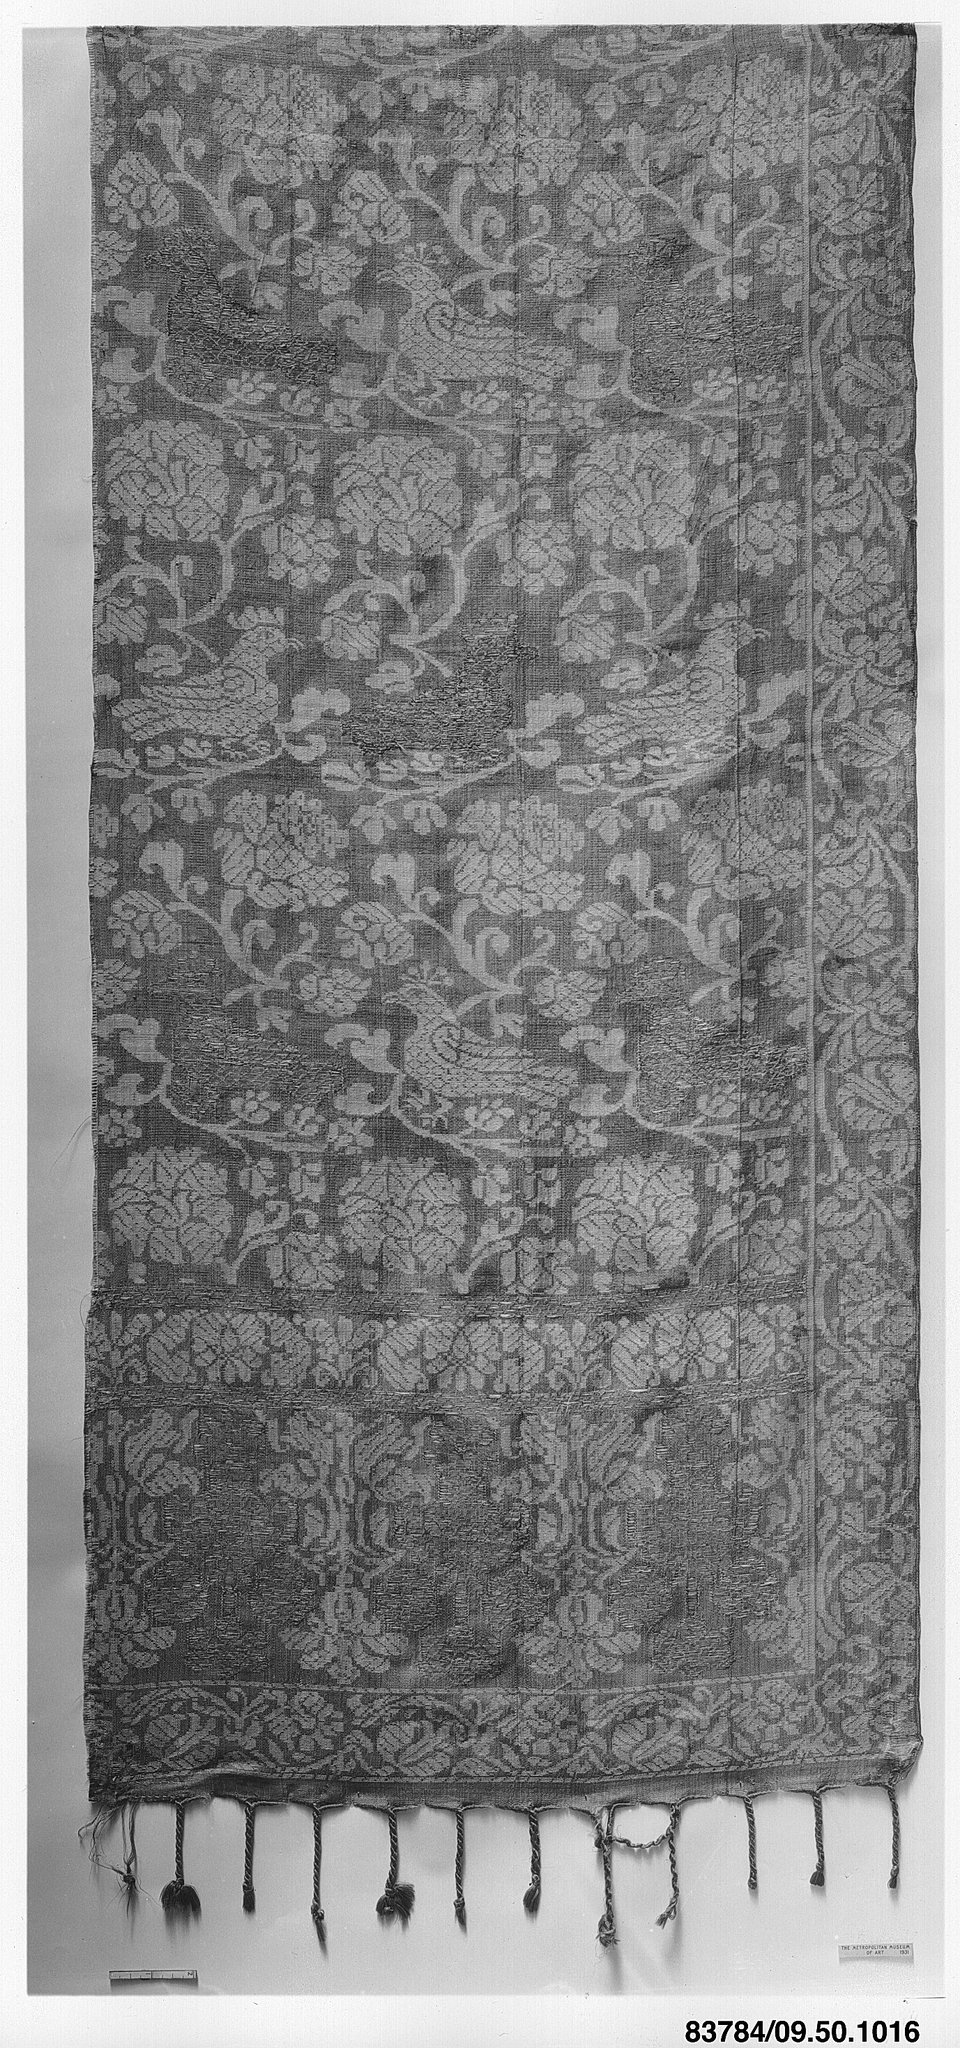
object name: fragment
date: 1700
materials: metal thread, silk